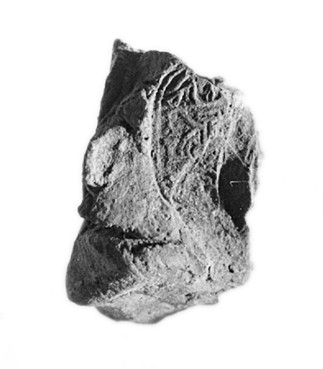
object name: sealing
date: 1981-1640 BCE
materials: mud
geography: egypt